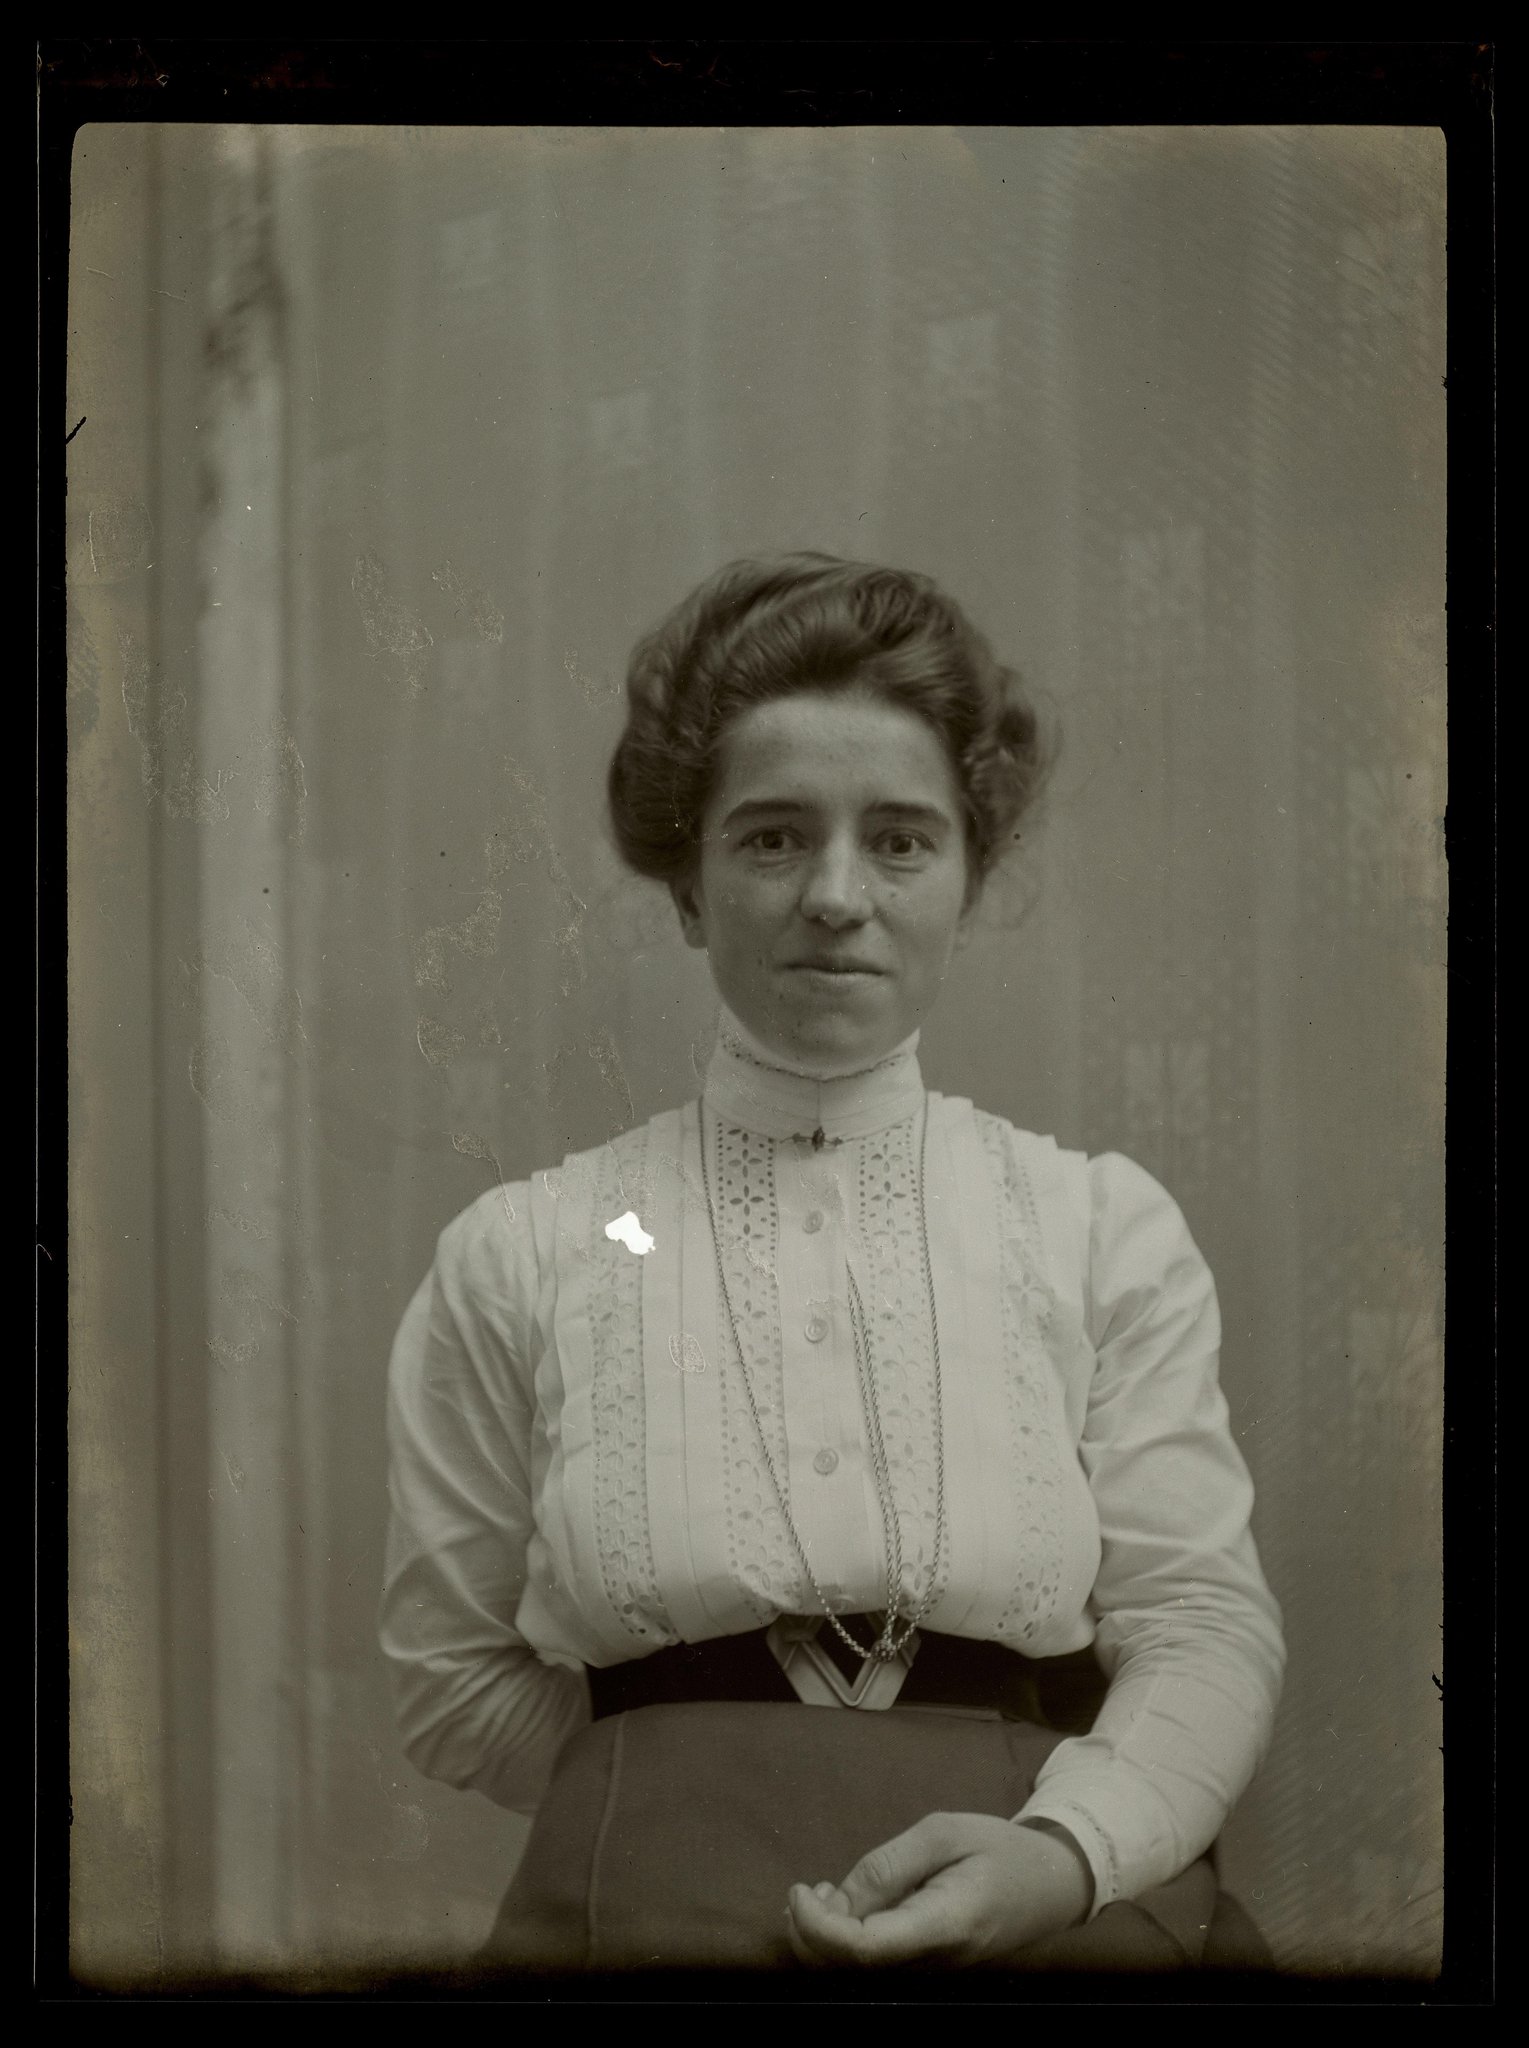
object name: negative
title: Filmnegatief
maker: Anonymous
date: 1907-1935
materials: film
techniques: gelatin silver negative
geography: europe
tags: europe